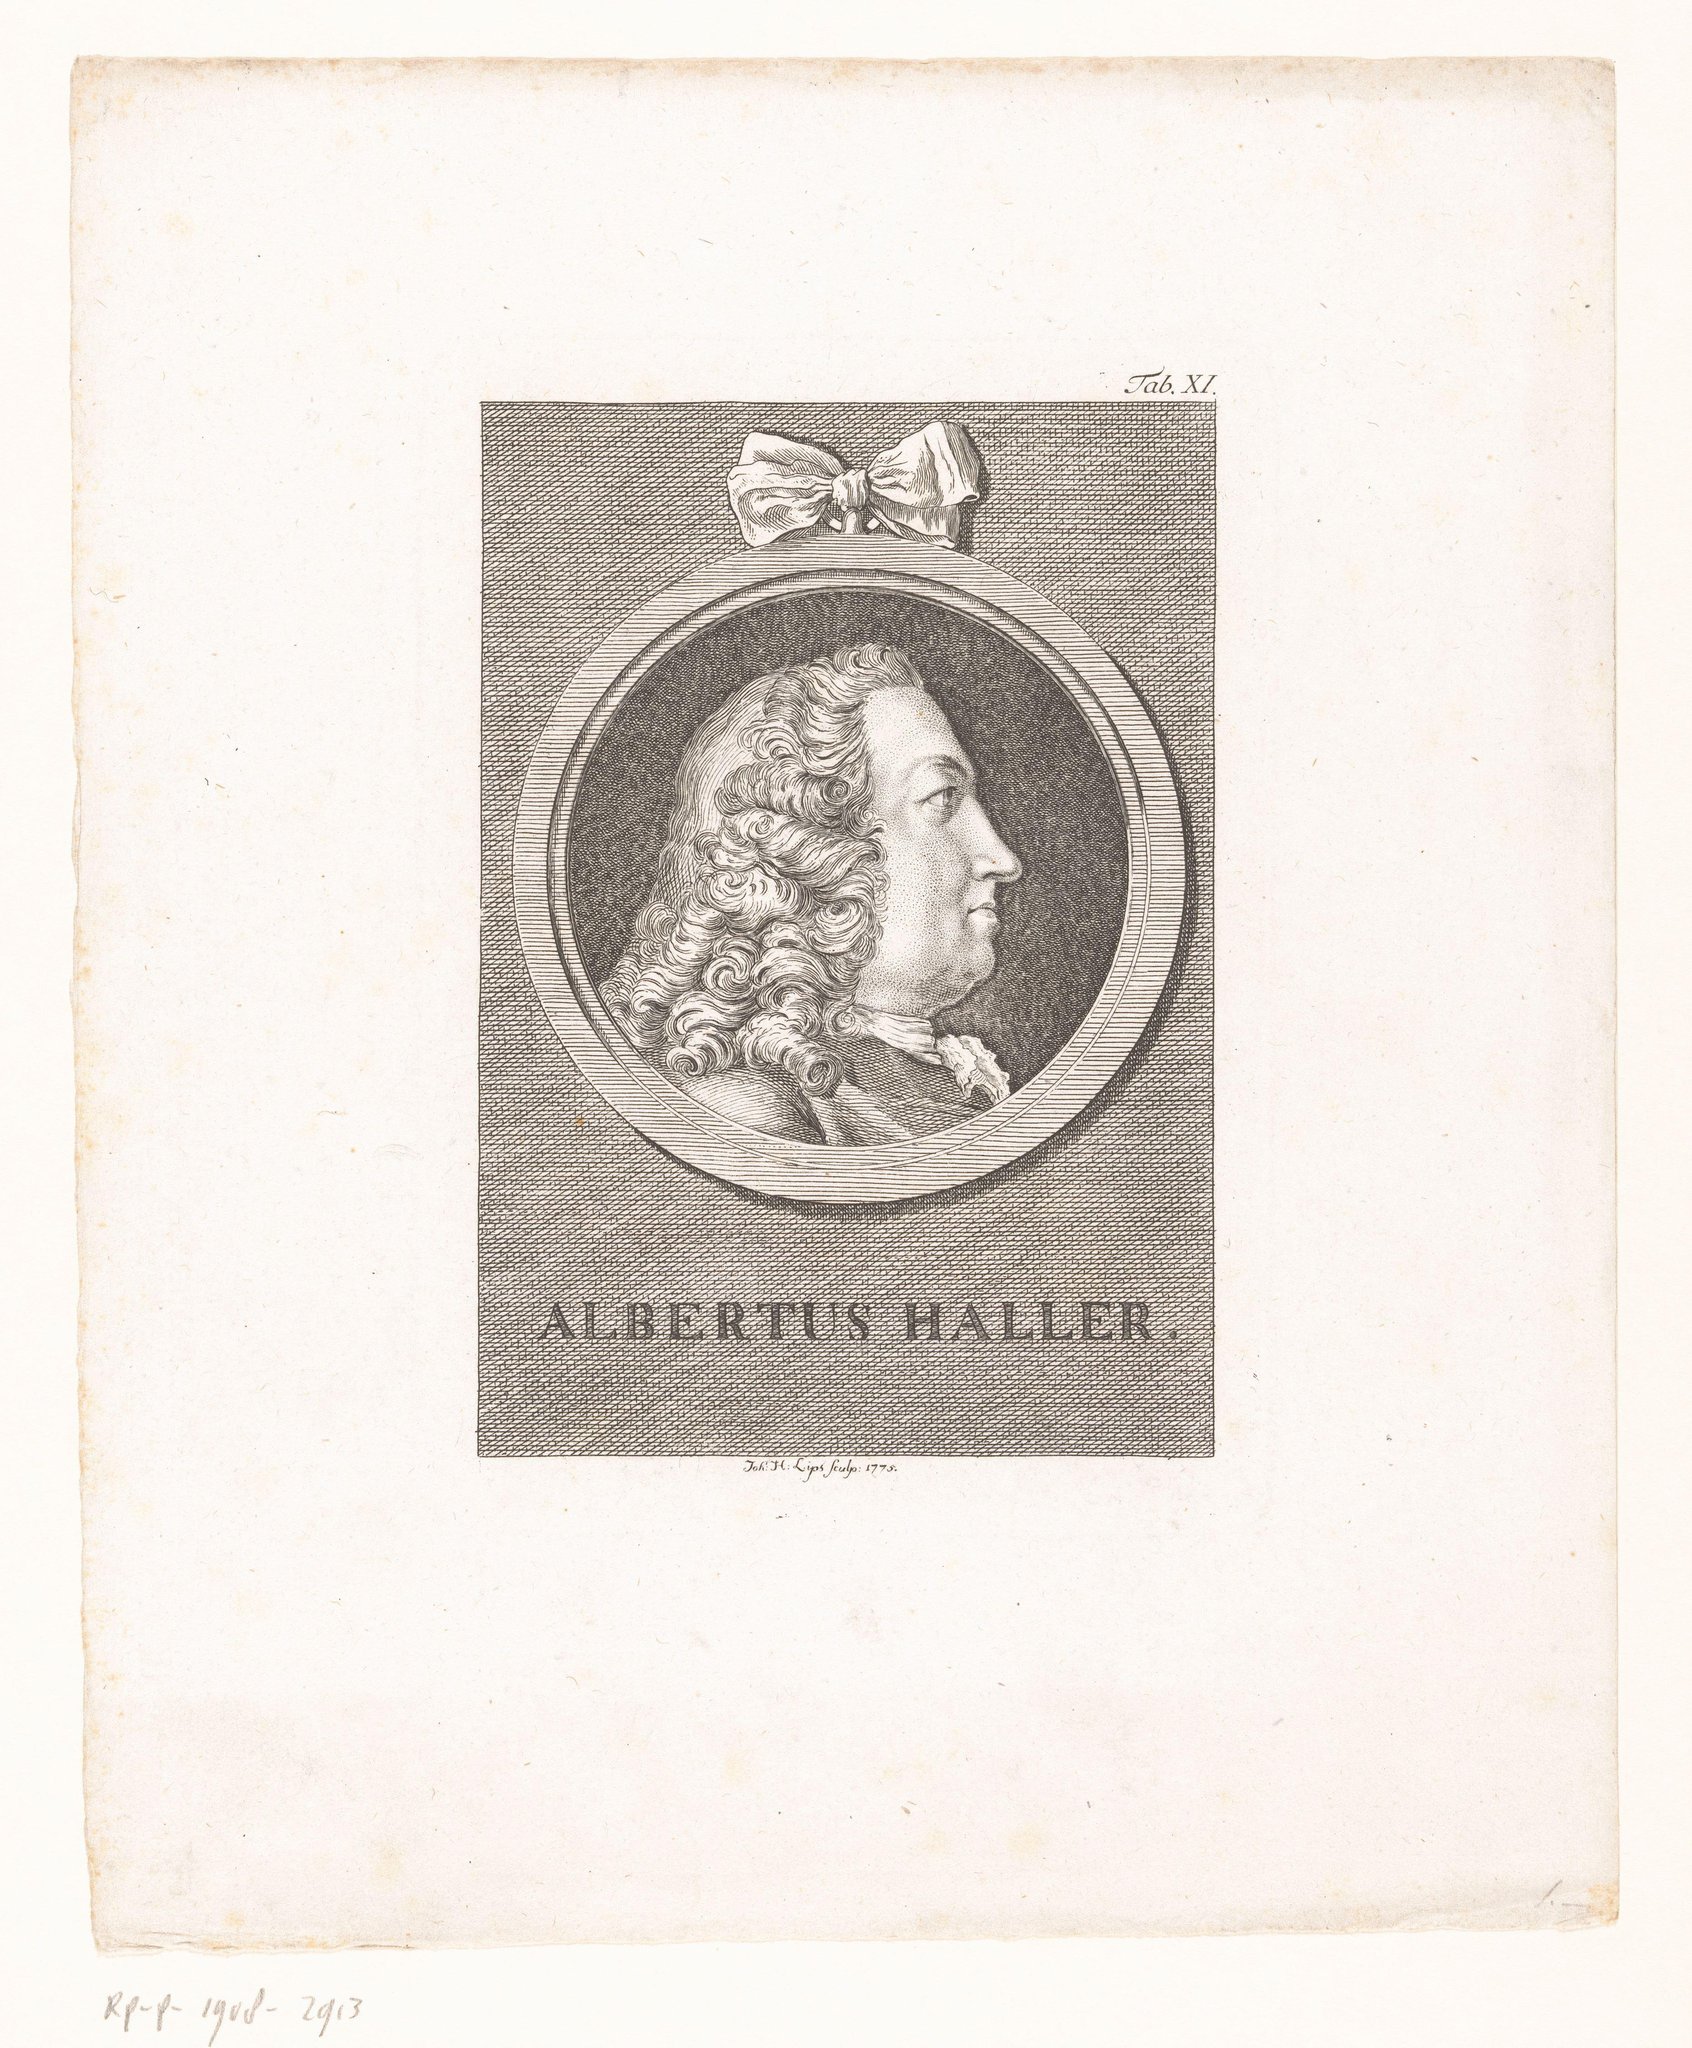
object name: print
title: Portret van Albrecht Haller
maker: johann heinrich lips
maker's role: draughtsman, painter, print maker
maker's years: 1758-1817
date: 1775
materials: paper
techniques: engraving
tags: physicist, historical persons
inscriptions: collector's mark: Lugt 2228